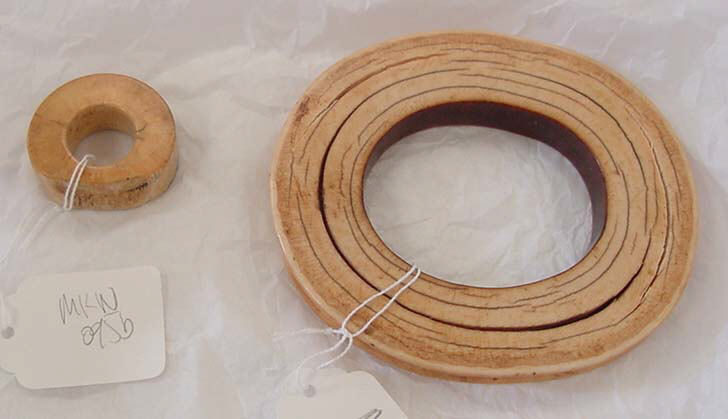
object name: jewelry set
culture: african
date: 1801-1900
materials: ivory